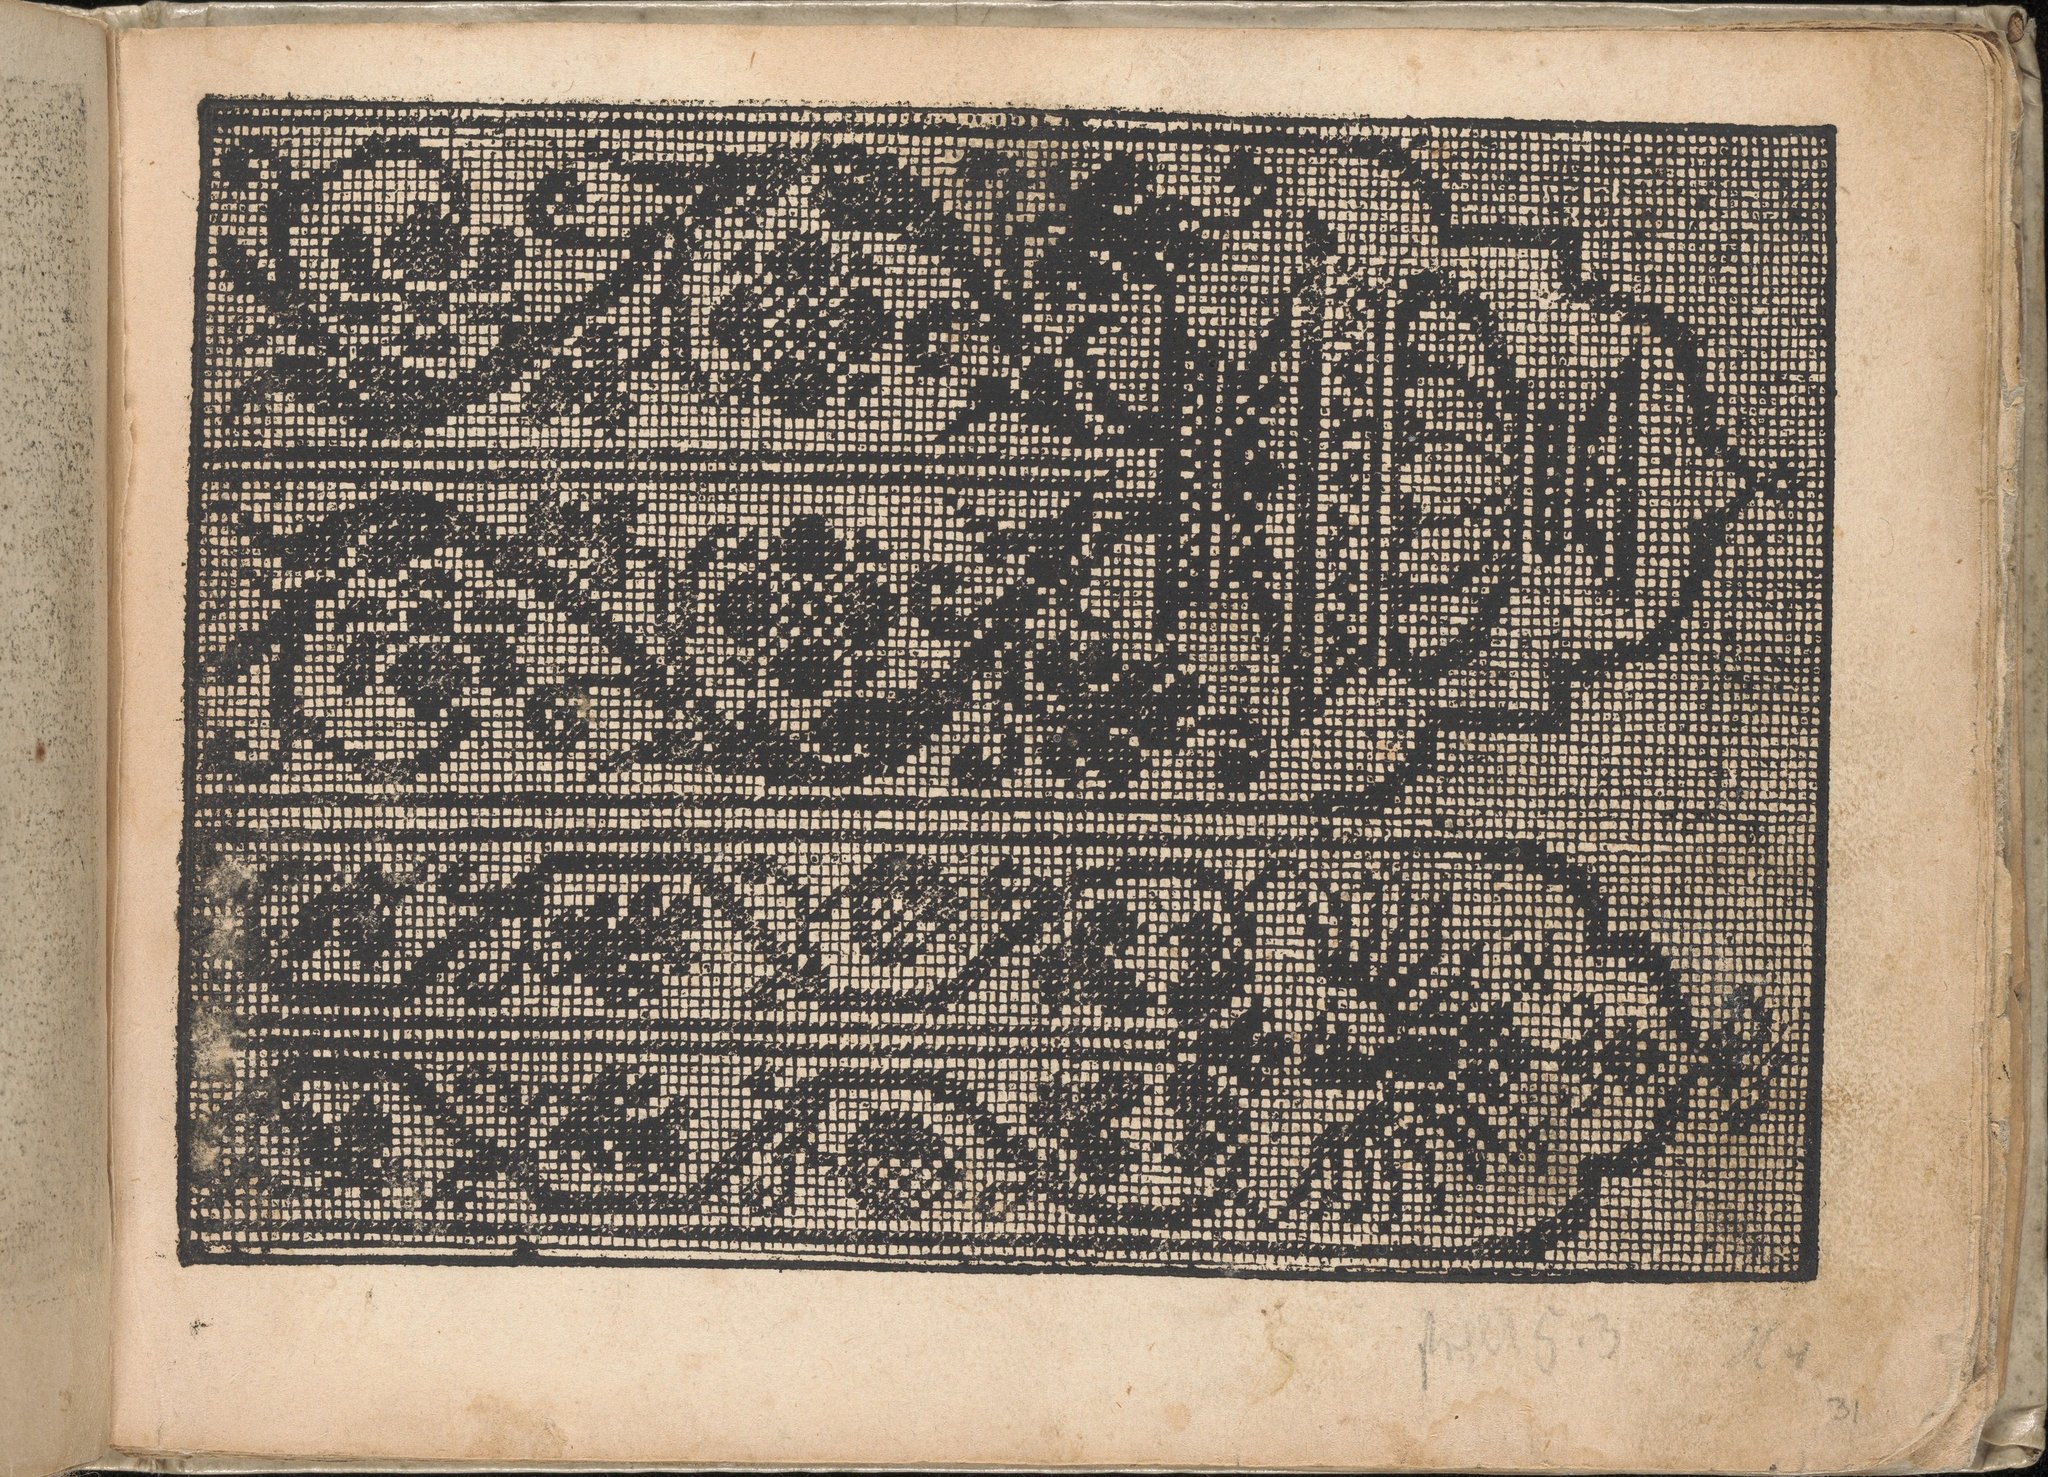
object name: book print ornament architecture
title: Neu künstlich Modelbuch (page 31r)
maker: bernhard jobin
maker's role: publisher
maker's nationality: swiss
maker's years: 1535-1597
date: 1598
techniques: woodcut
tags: flowers